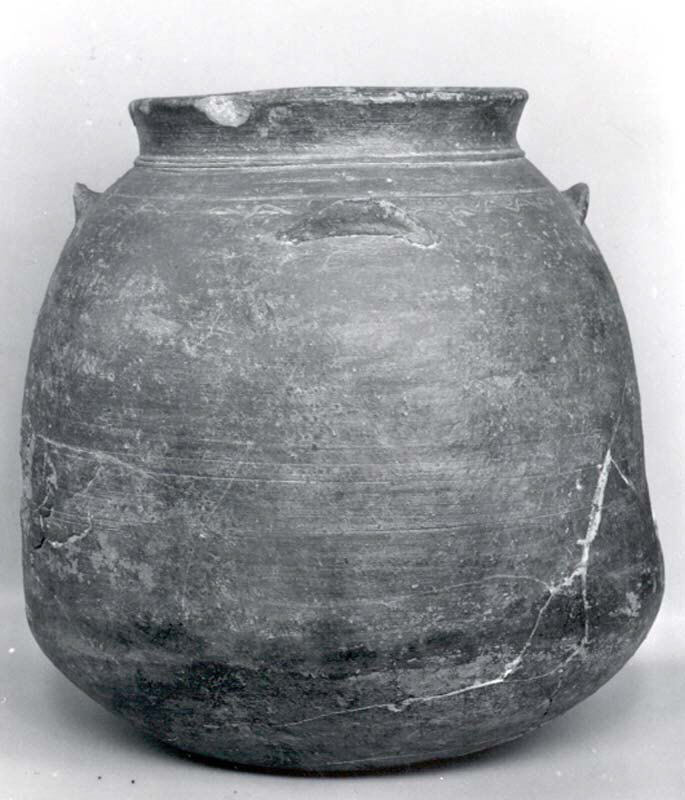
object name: jar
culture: sasanian or islamic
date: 501-800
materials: ceramic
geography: iran